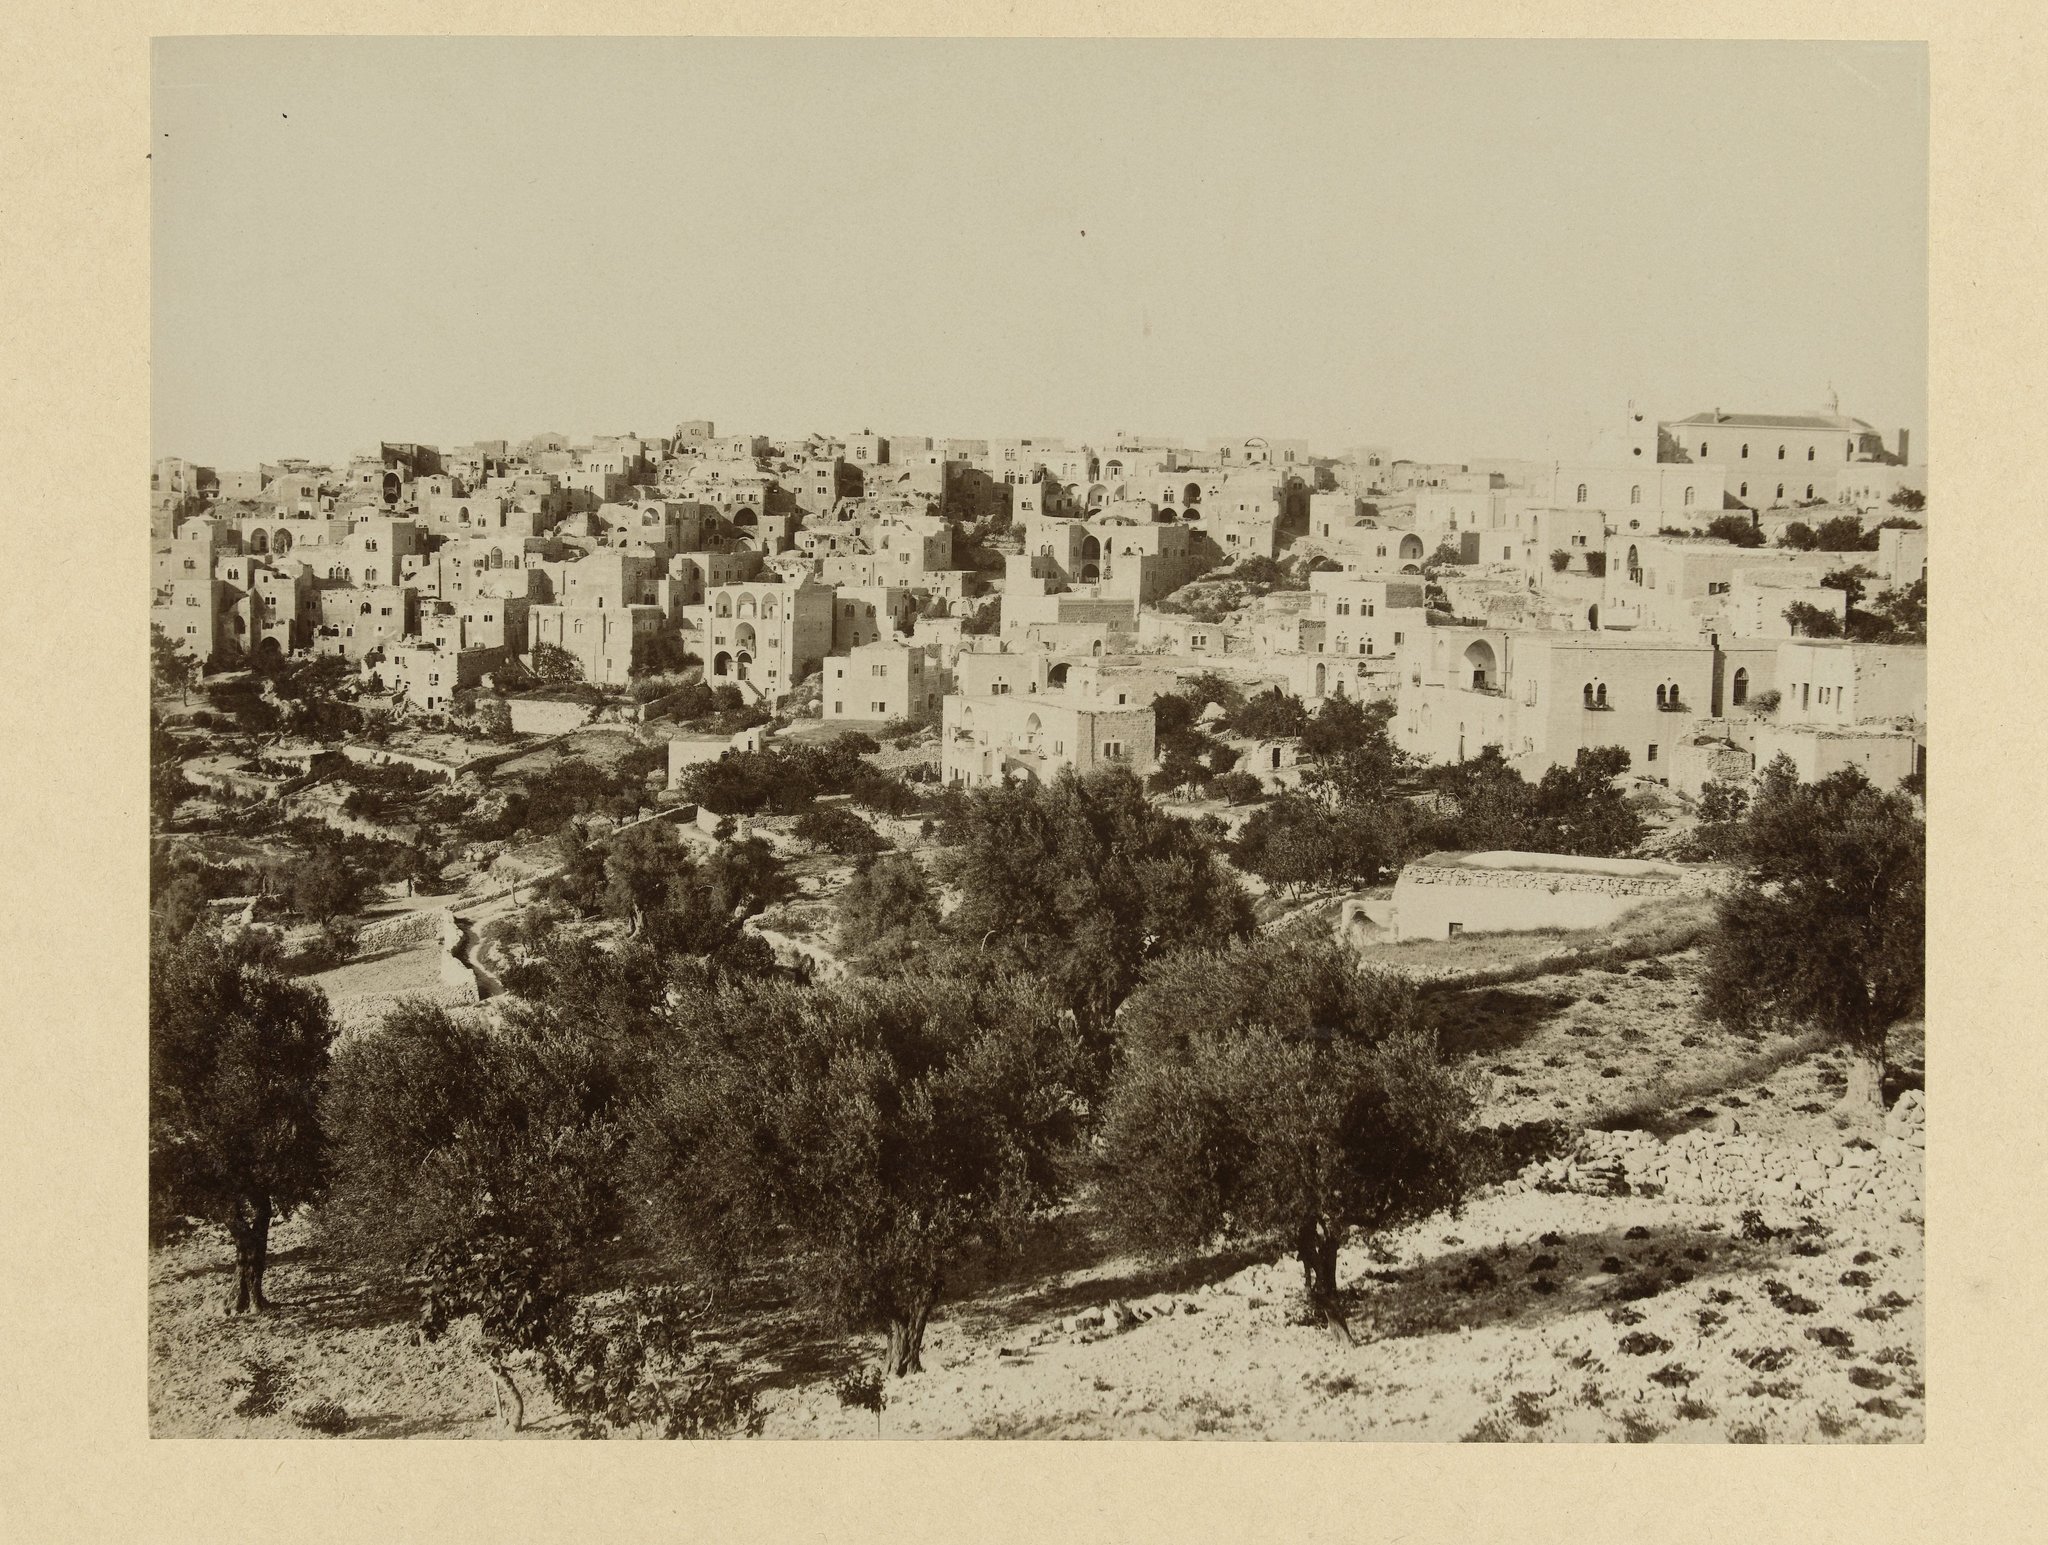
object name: photograph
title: S 51. Gezicht op Bethlehem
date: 1870-1895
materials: cardboard, paper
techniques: albumen print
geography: ottoman empire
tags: prospect of village, silhouette of village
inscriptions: check stamp: ‘Bristol/ L.M.’, title: ‘S 51. Gezicht op Bethlehem.’, inscription: ‘[...] Bethleem’, stamp: ‘Gemeentelijke bibliotheek/ Rotterdam’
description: Onderdeel van een groep door fotograaf Richard Polak op reis verzamelde foto’s. Deze foto is samen met andere op zijn reizen verzamelde foto's tentoongesteld bij de Rotterdamsche Kunstkring (1895), Arti en Amicitiae te Amsterdam (1897-1898?) en Societeit 't Collegie te Kampen (datum vooralsnog onbekend).